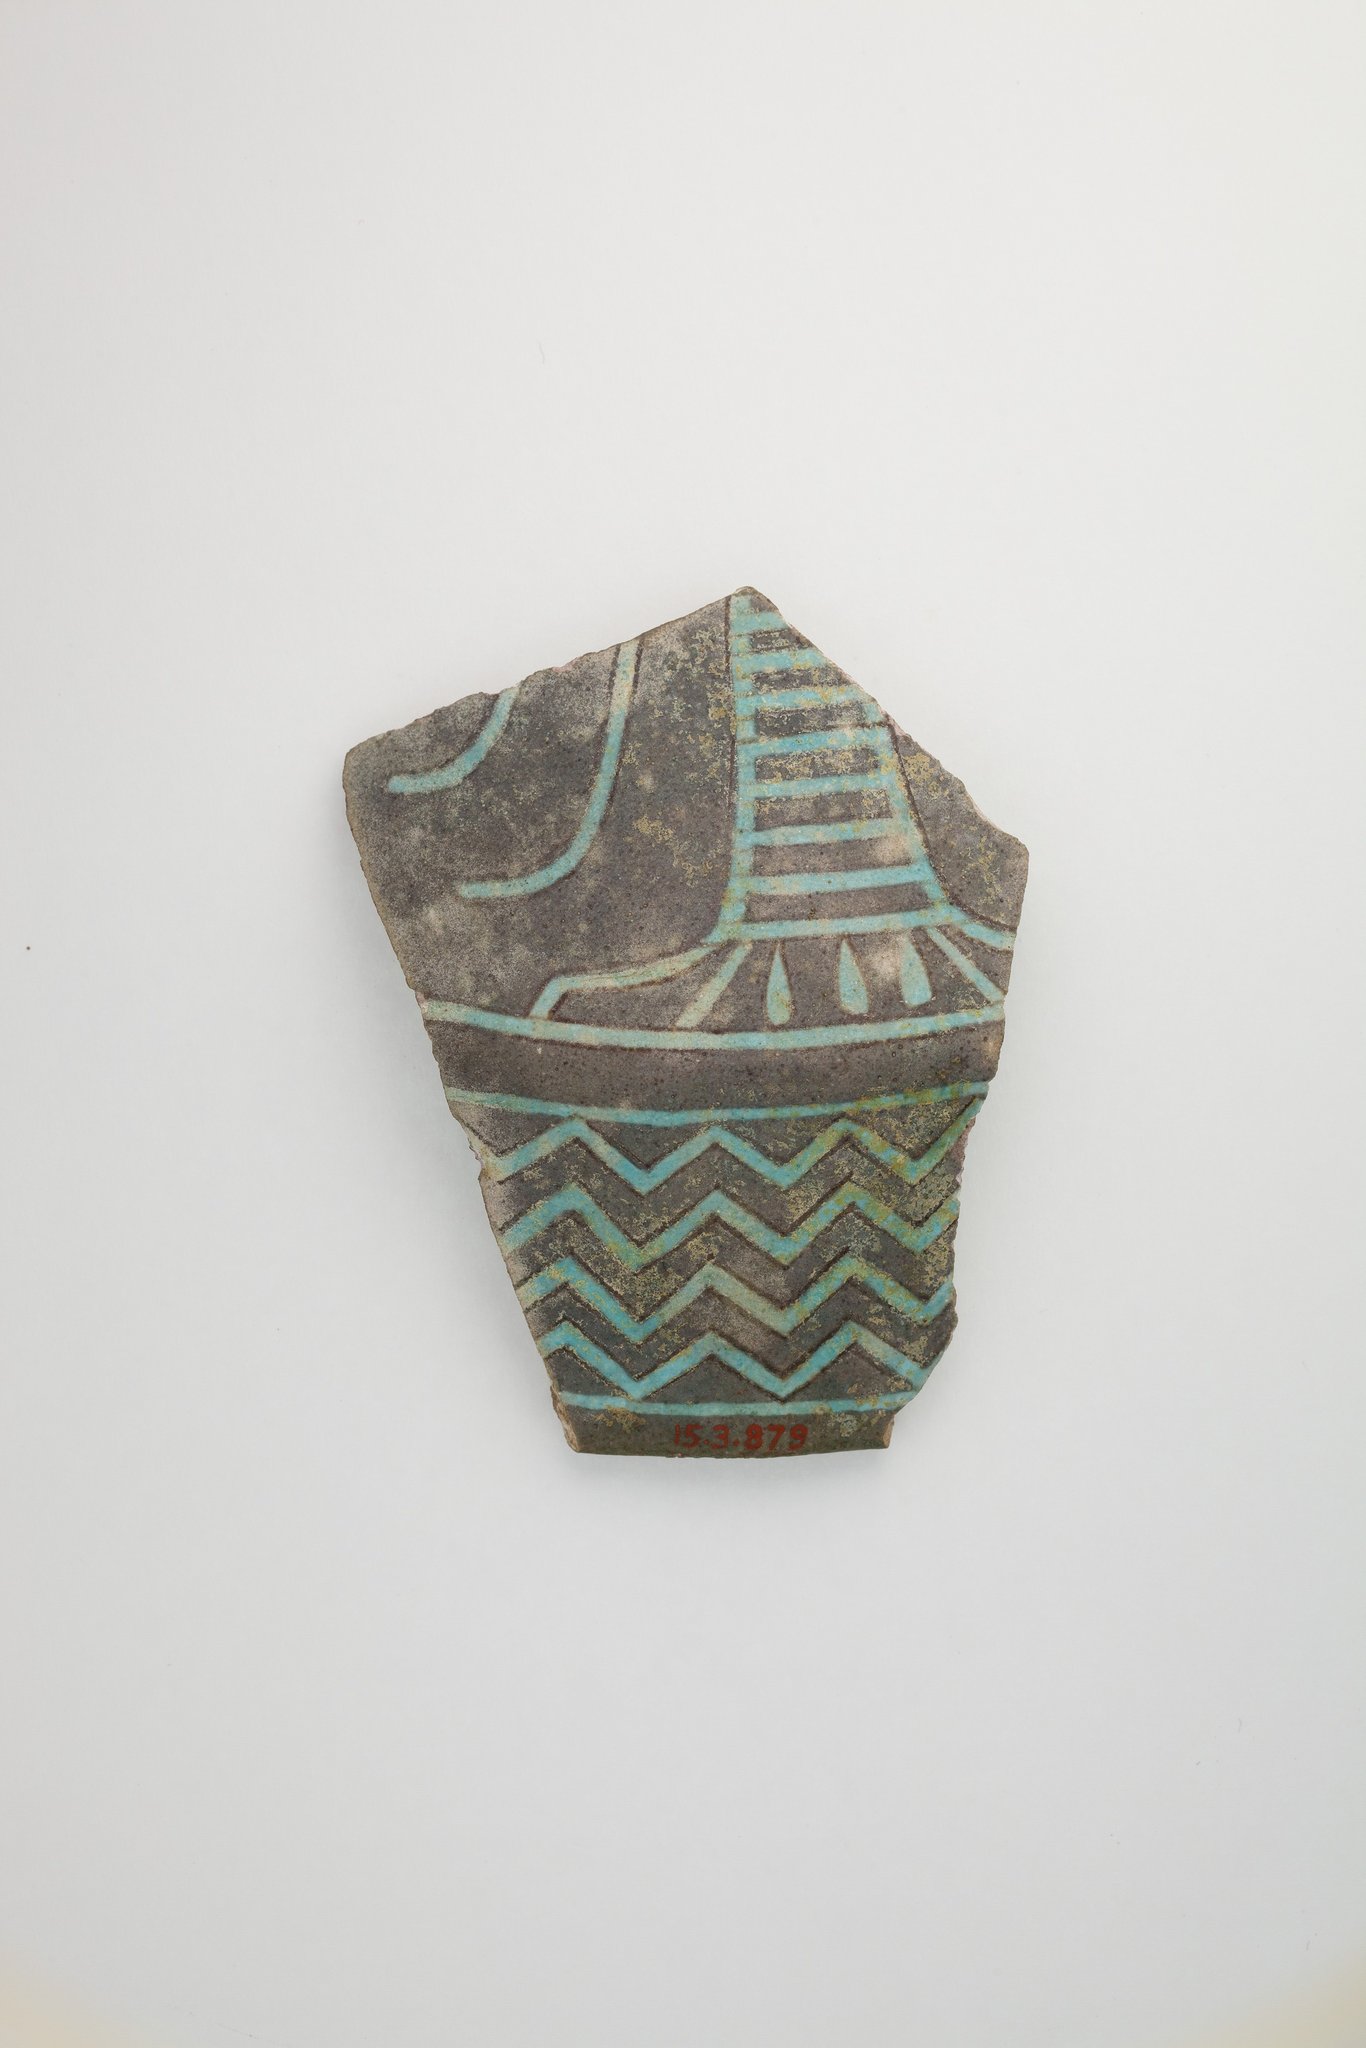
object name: fragment of a bowl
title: Bowl fragment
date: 1981-1640 BCE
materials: faience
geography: egypt